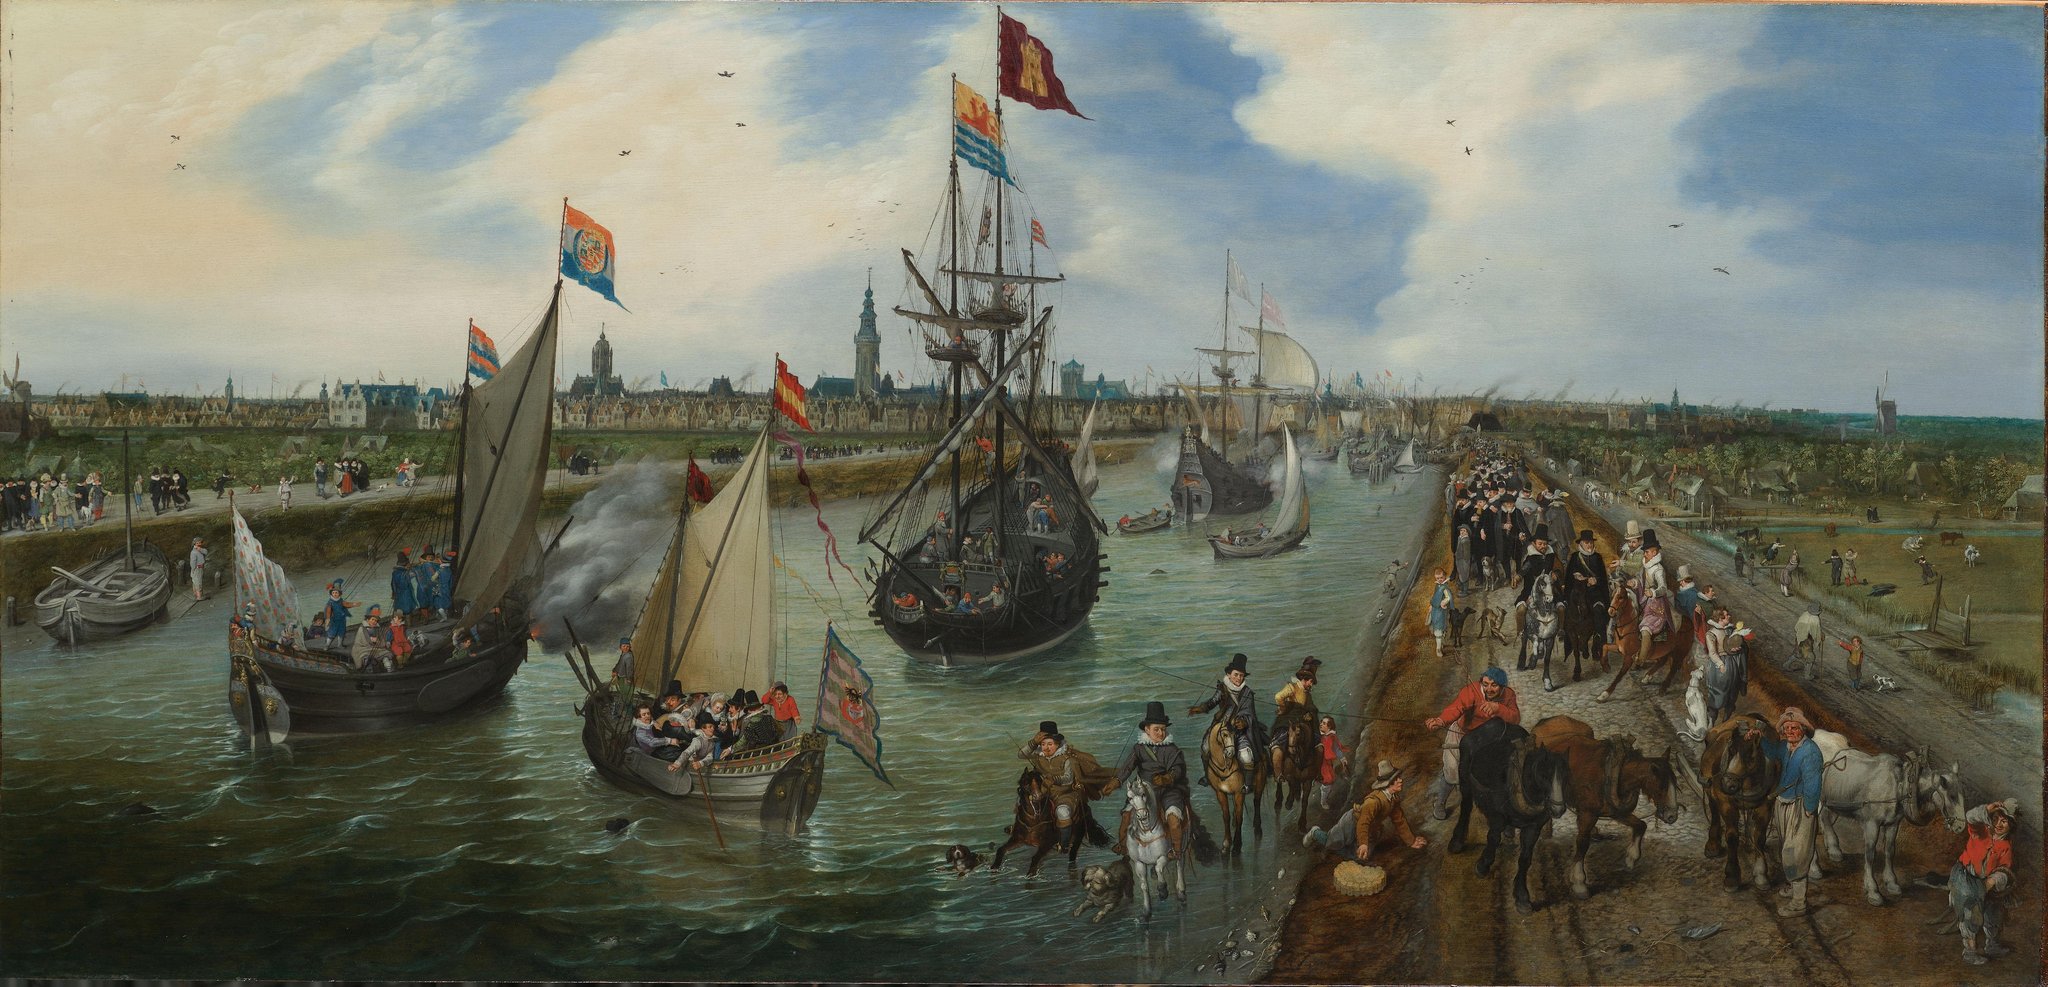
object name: painting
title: The Departure of a Dignitary from Middelburg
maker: adriaen pietersz van de venne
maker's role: draughtsman, painter, print maker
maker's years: 1589-1662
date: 1615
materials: oil, panel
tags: maurice (prince of orange), sailing-ship, sailing-boat, city-view in general; 'veduta', canal, middelburg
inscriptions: signature and date, bottom centre: ‘AV VENNE 1615’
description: All of Middelburg has turned out to watch the warship De Zeehondt is being towed out of the harbour, towards the sea, with the help of four sturdy draught horses. Someone of distinction is leaving here, because even Stadholder Maurice’s yacht takes part: it is firing a gun salute. The presence of an African child on the middle ship is notable.